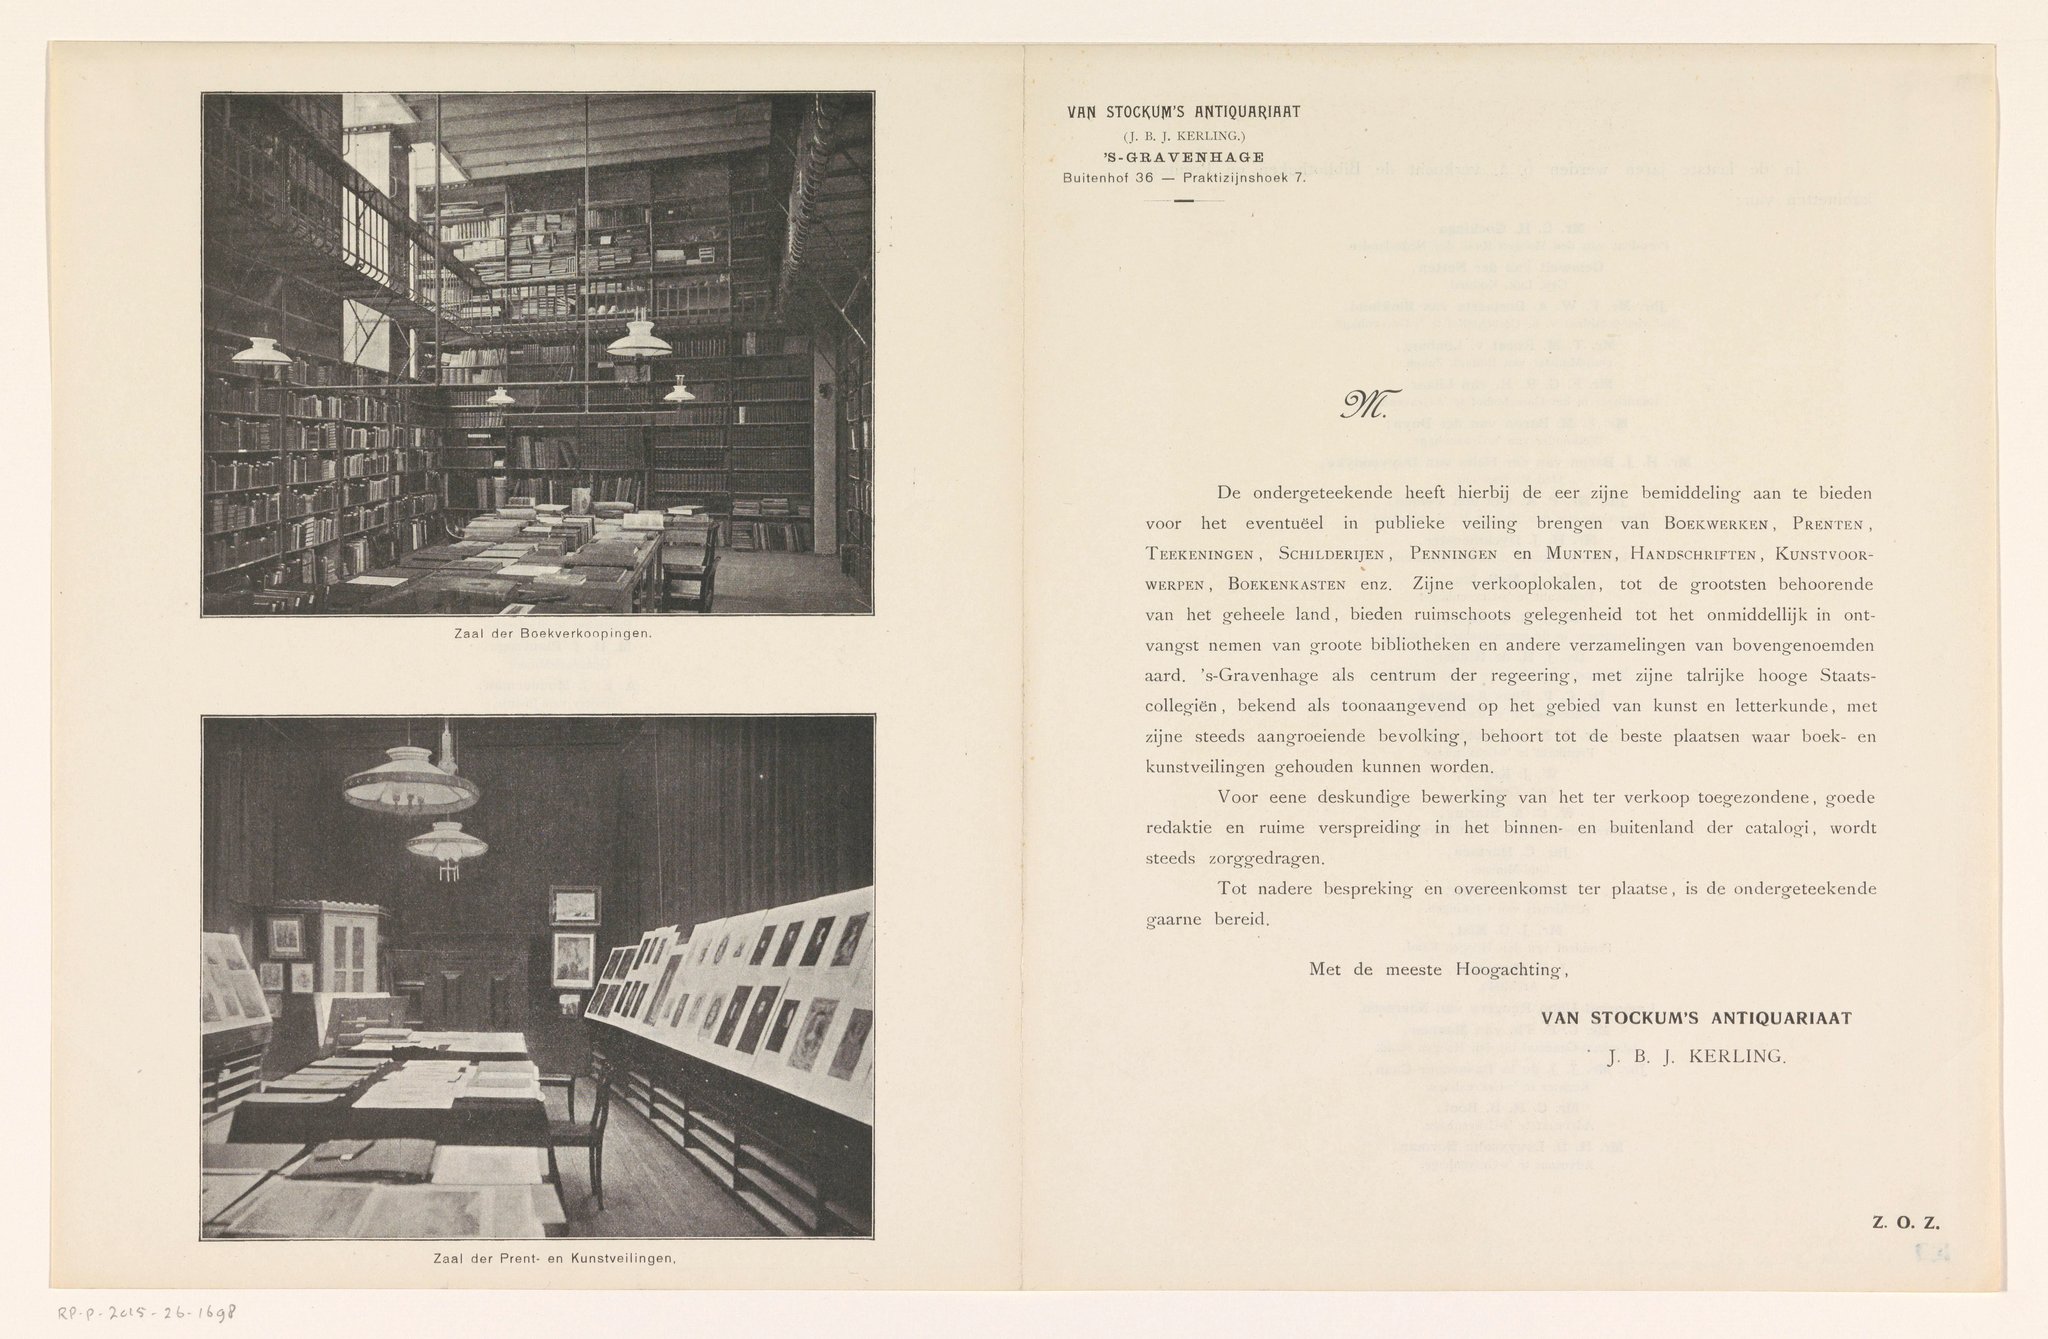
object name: photograph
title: Interieur van Van Stockum's Antiquariaat te Den Haag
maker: Anonymous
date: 1907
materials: paper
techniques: autotype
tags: bookshelves, print, e.g.: engraving, etching, lithograph, art sale, auction, the hague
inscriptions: collector's mark: Lugt 2228, collector's mark: Lugt 4780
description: De foto's van het interieur zijn gebruikt op de achterzijde van een aanbevelingsbrief van J.B.J. Kerling van Van Stockum's Antquariaat. Aan de binnenzijde worden de collecties vermeld die de afgelopen jaren geveild zijn.